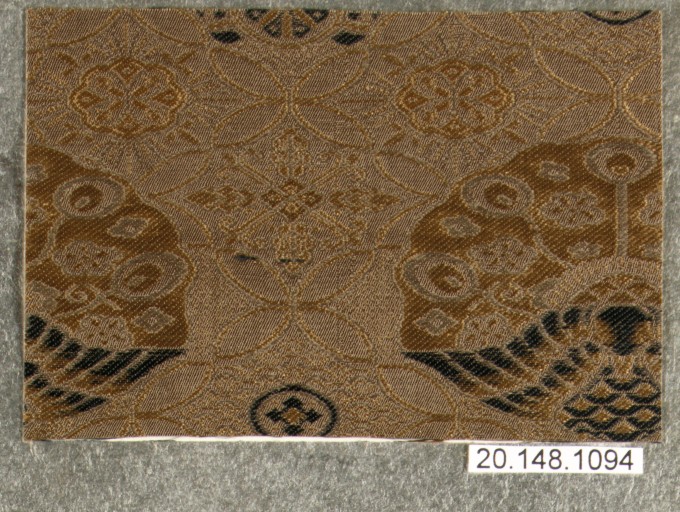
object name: piece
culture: japanese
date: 1701-1800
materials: silk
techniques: compound weave